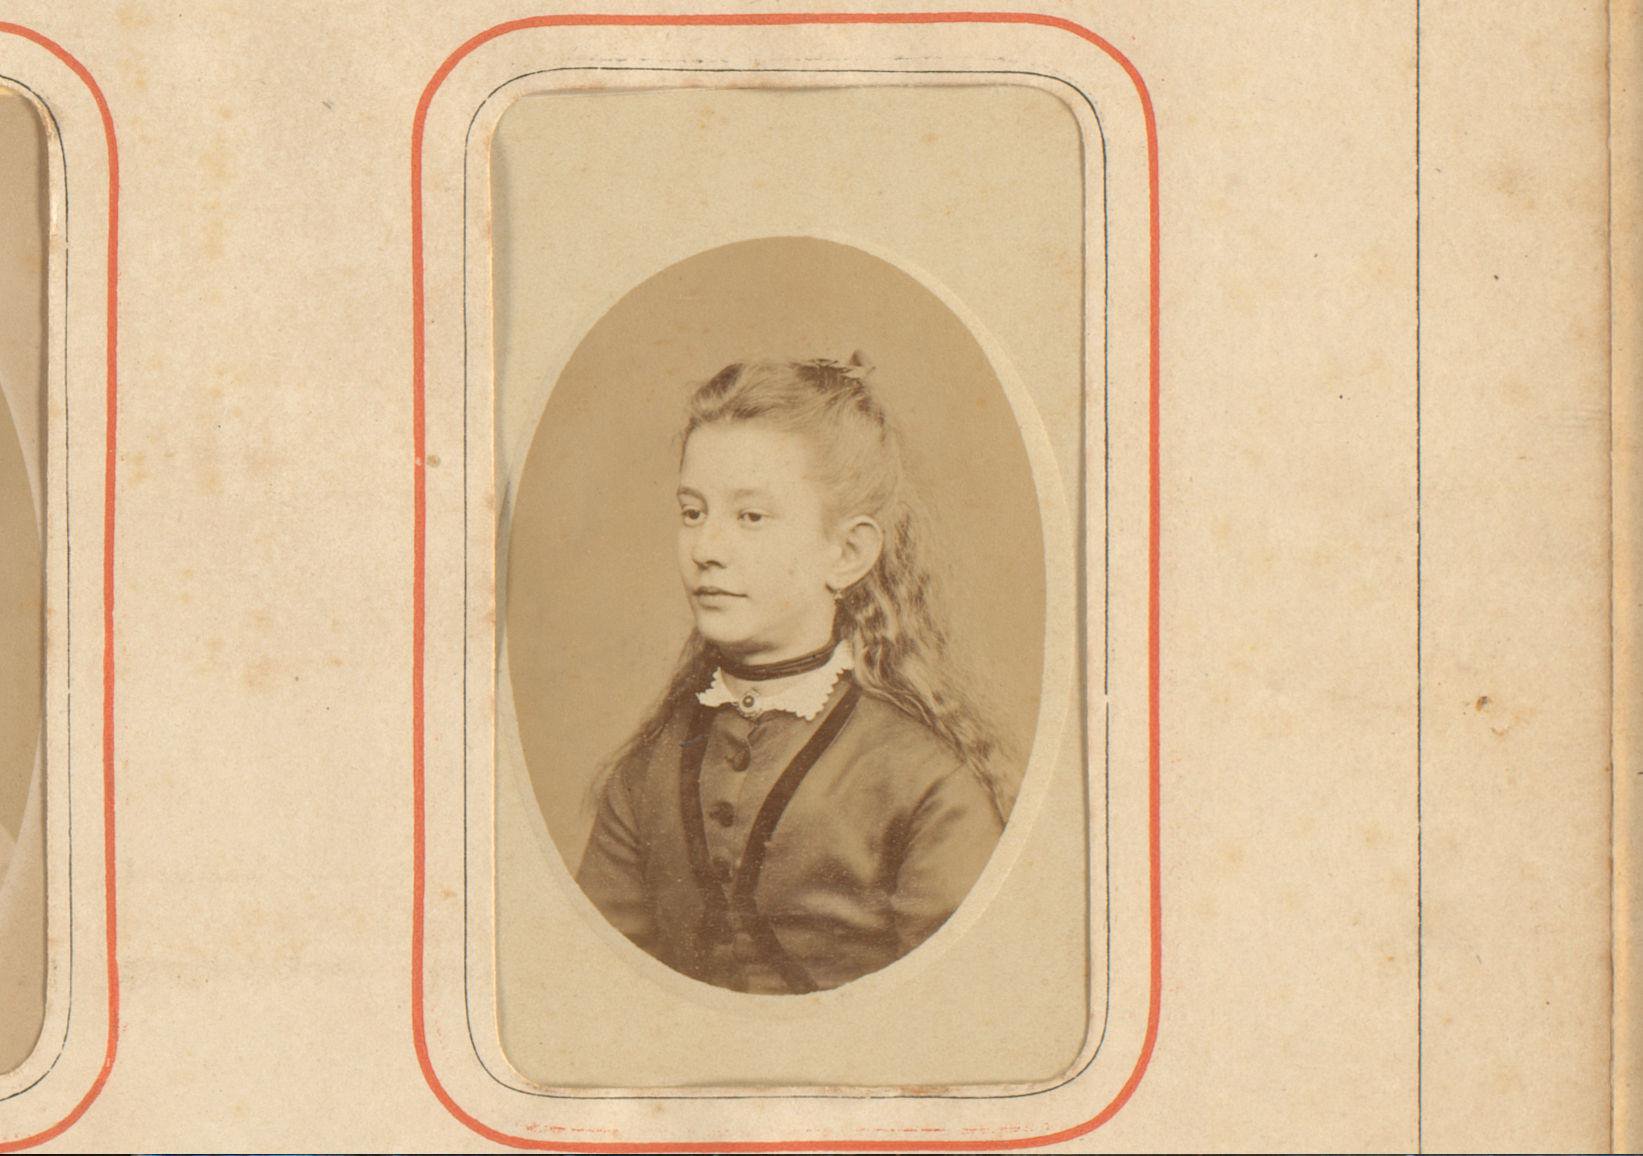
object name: carte de visite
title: Portret van een onbekend meisje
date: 1874-1883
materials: cardboard, paper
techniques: albumen print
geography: alkmaar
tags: anonymous historical person portrayed - bb - woman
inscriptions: address: ‘Verdonken Oord/ Wijk D. No 34./ ALKMAAR.’